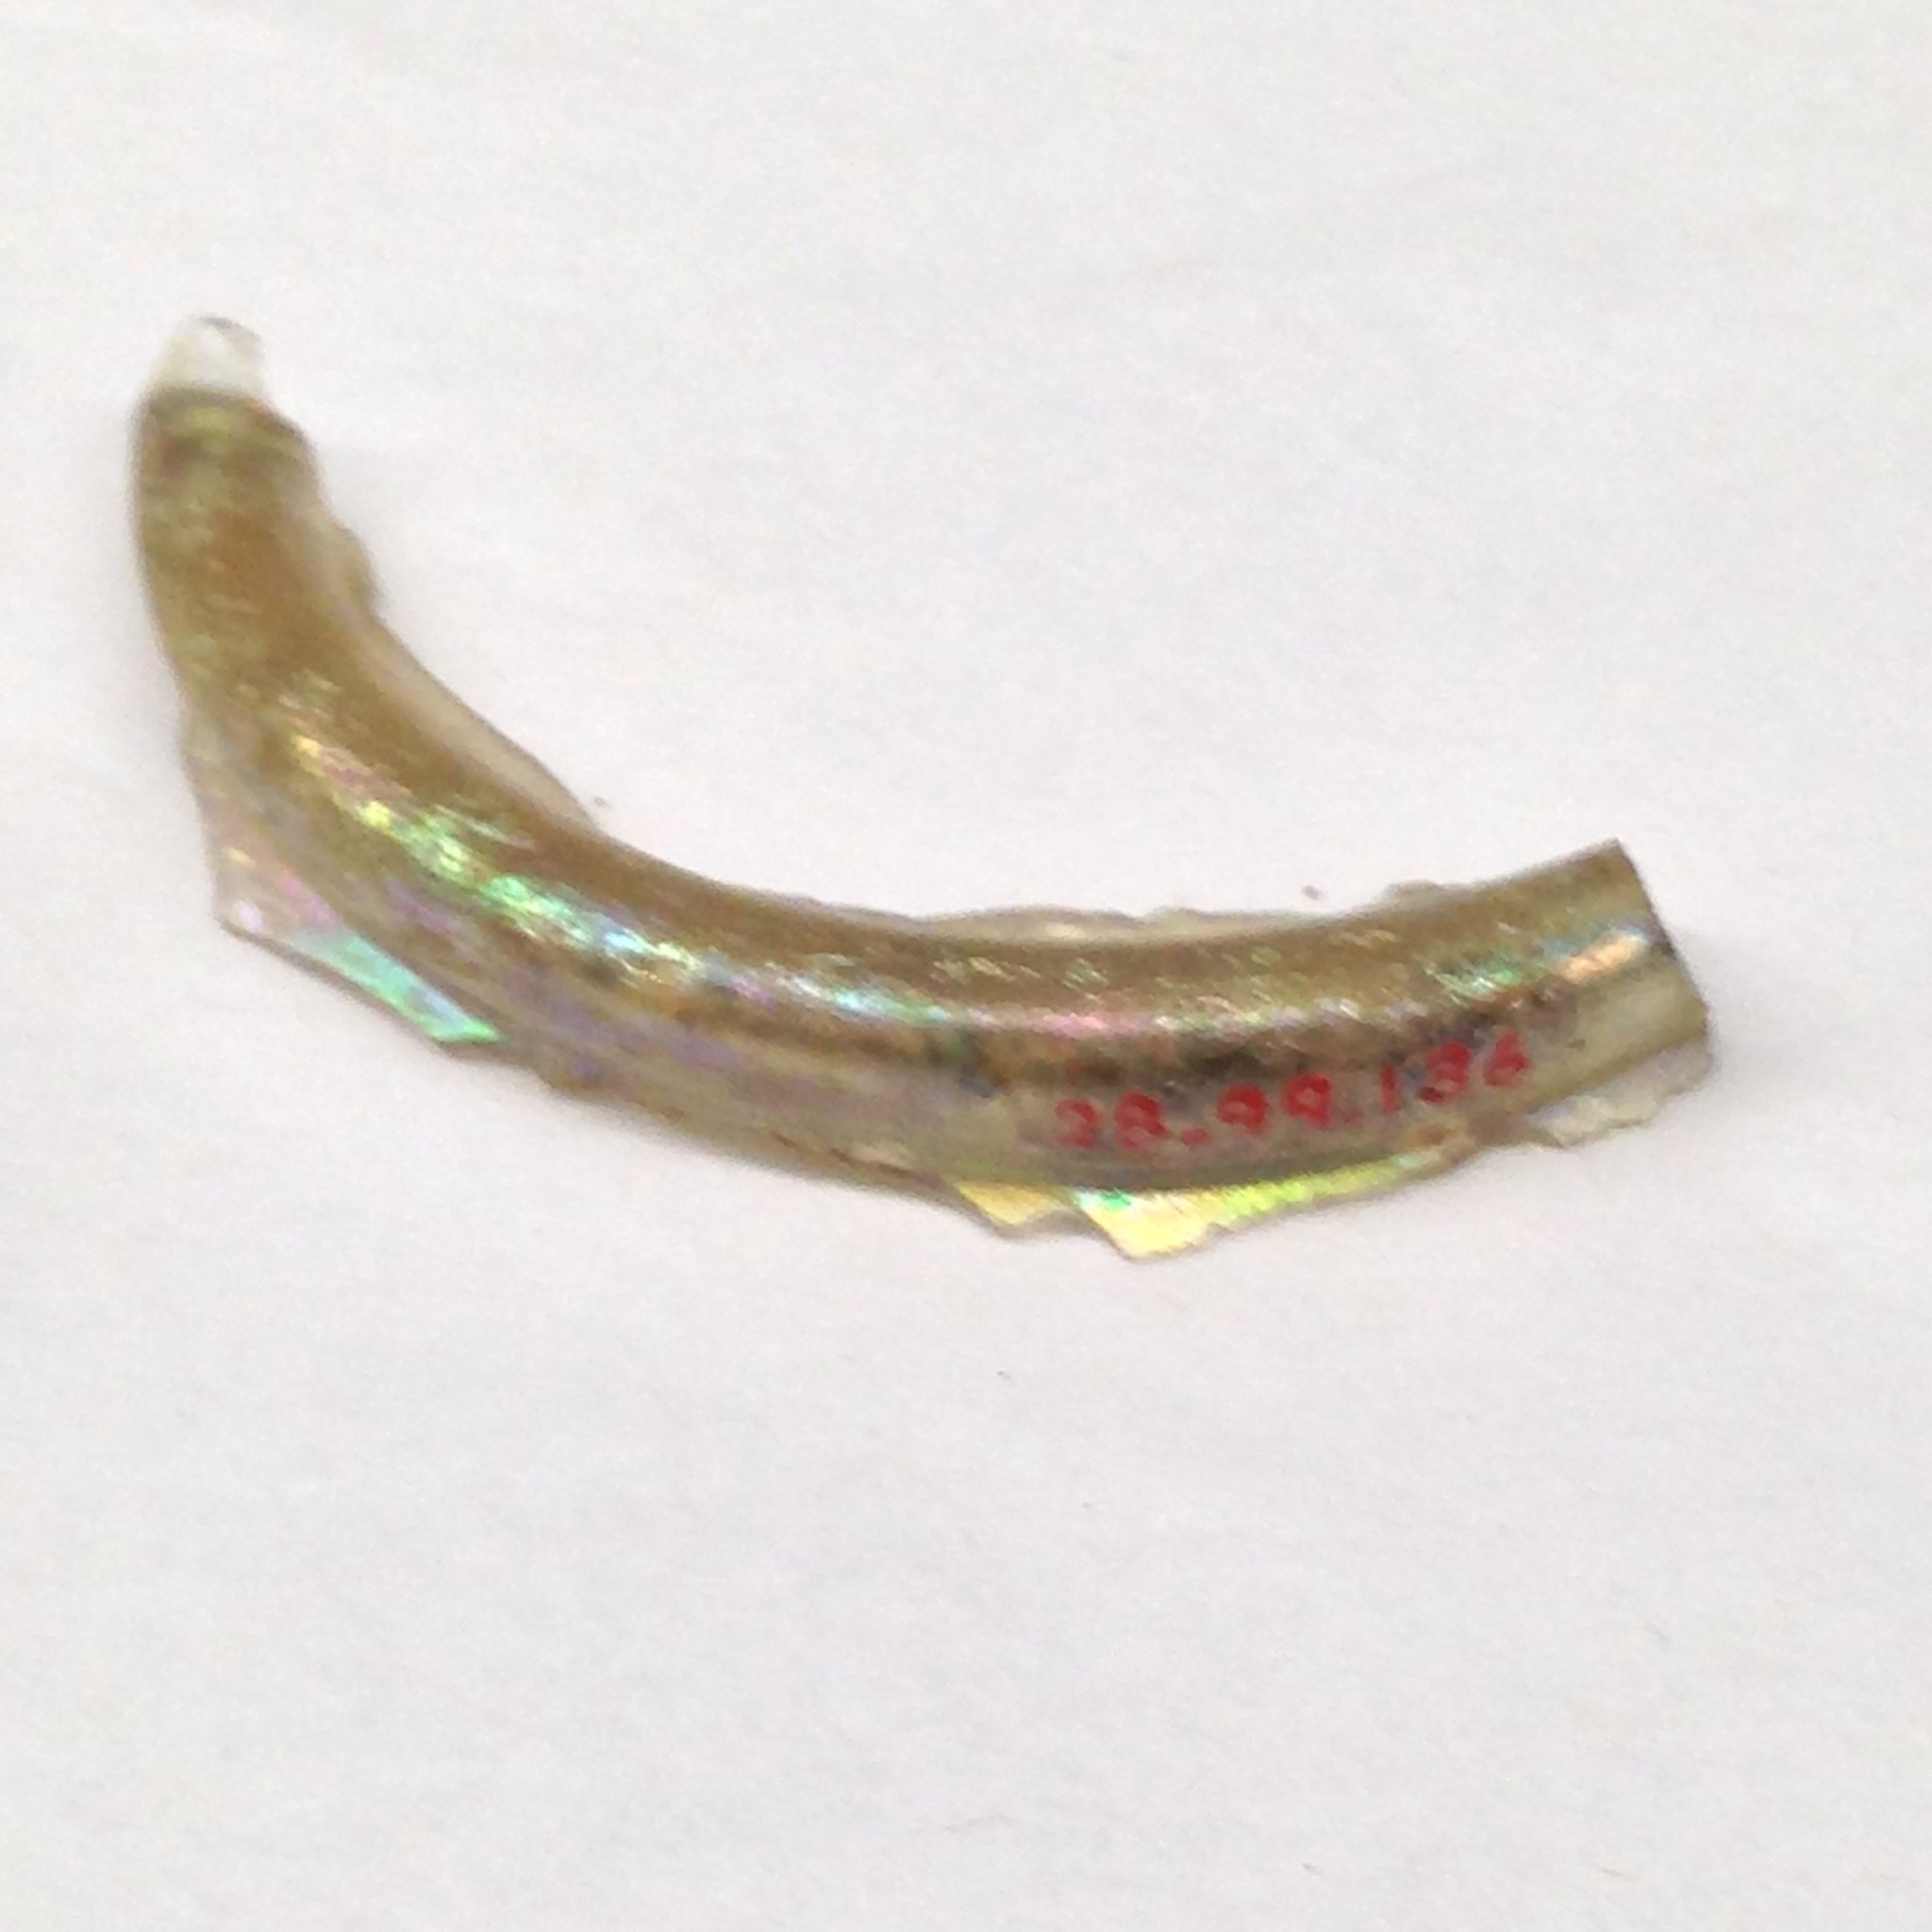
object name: fragment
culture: european or middle eastern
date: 1150-1250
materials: ceramic, glass